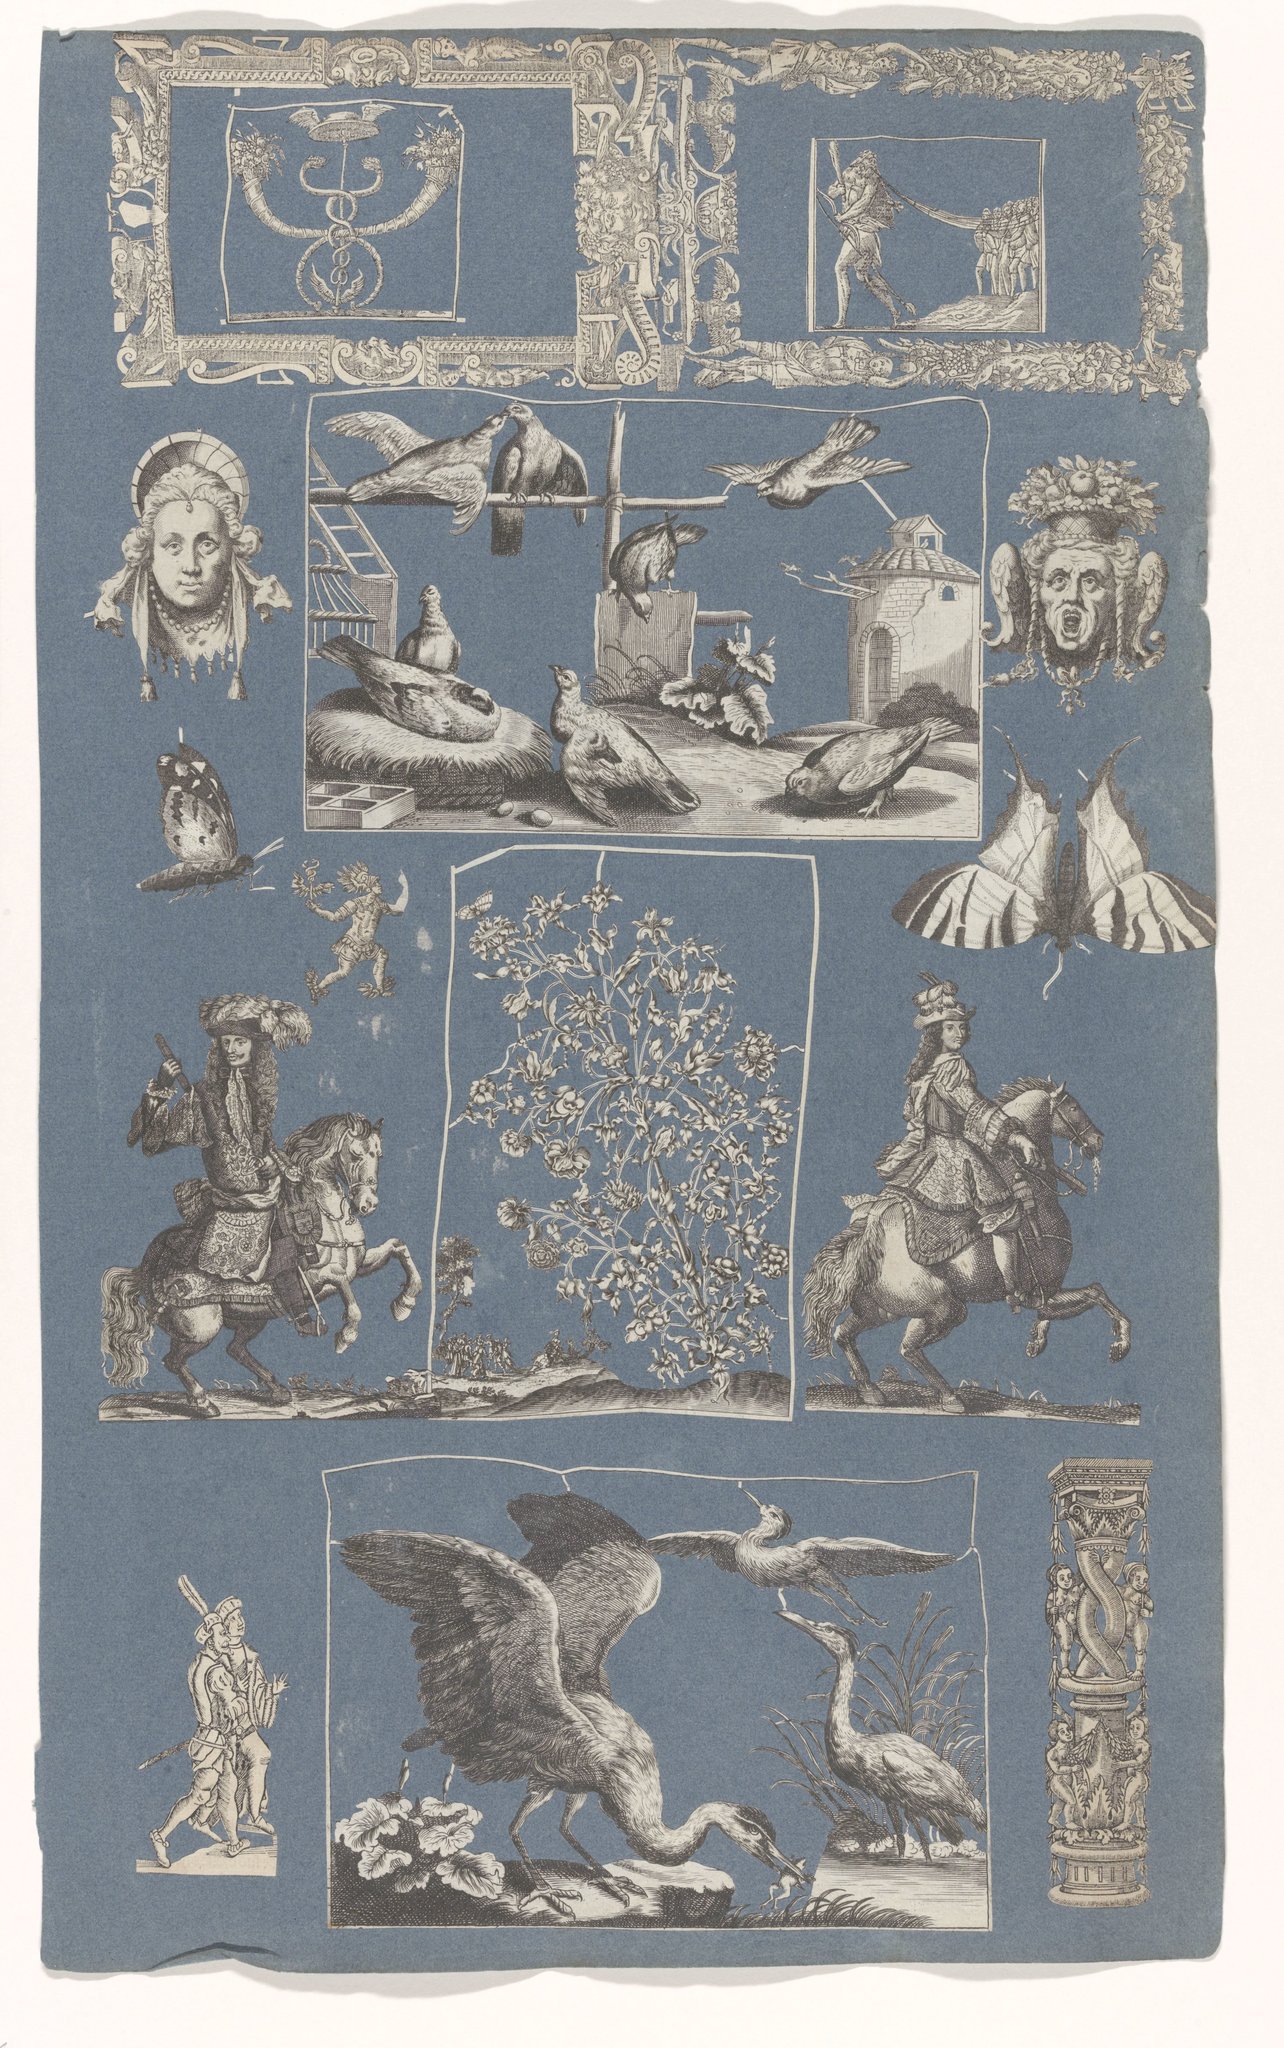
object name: collage visual work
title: Collage van uitgeknipte prenten geplakt op albumblad van blauw papier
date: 1585-1700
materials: paper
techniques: collage